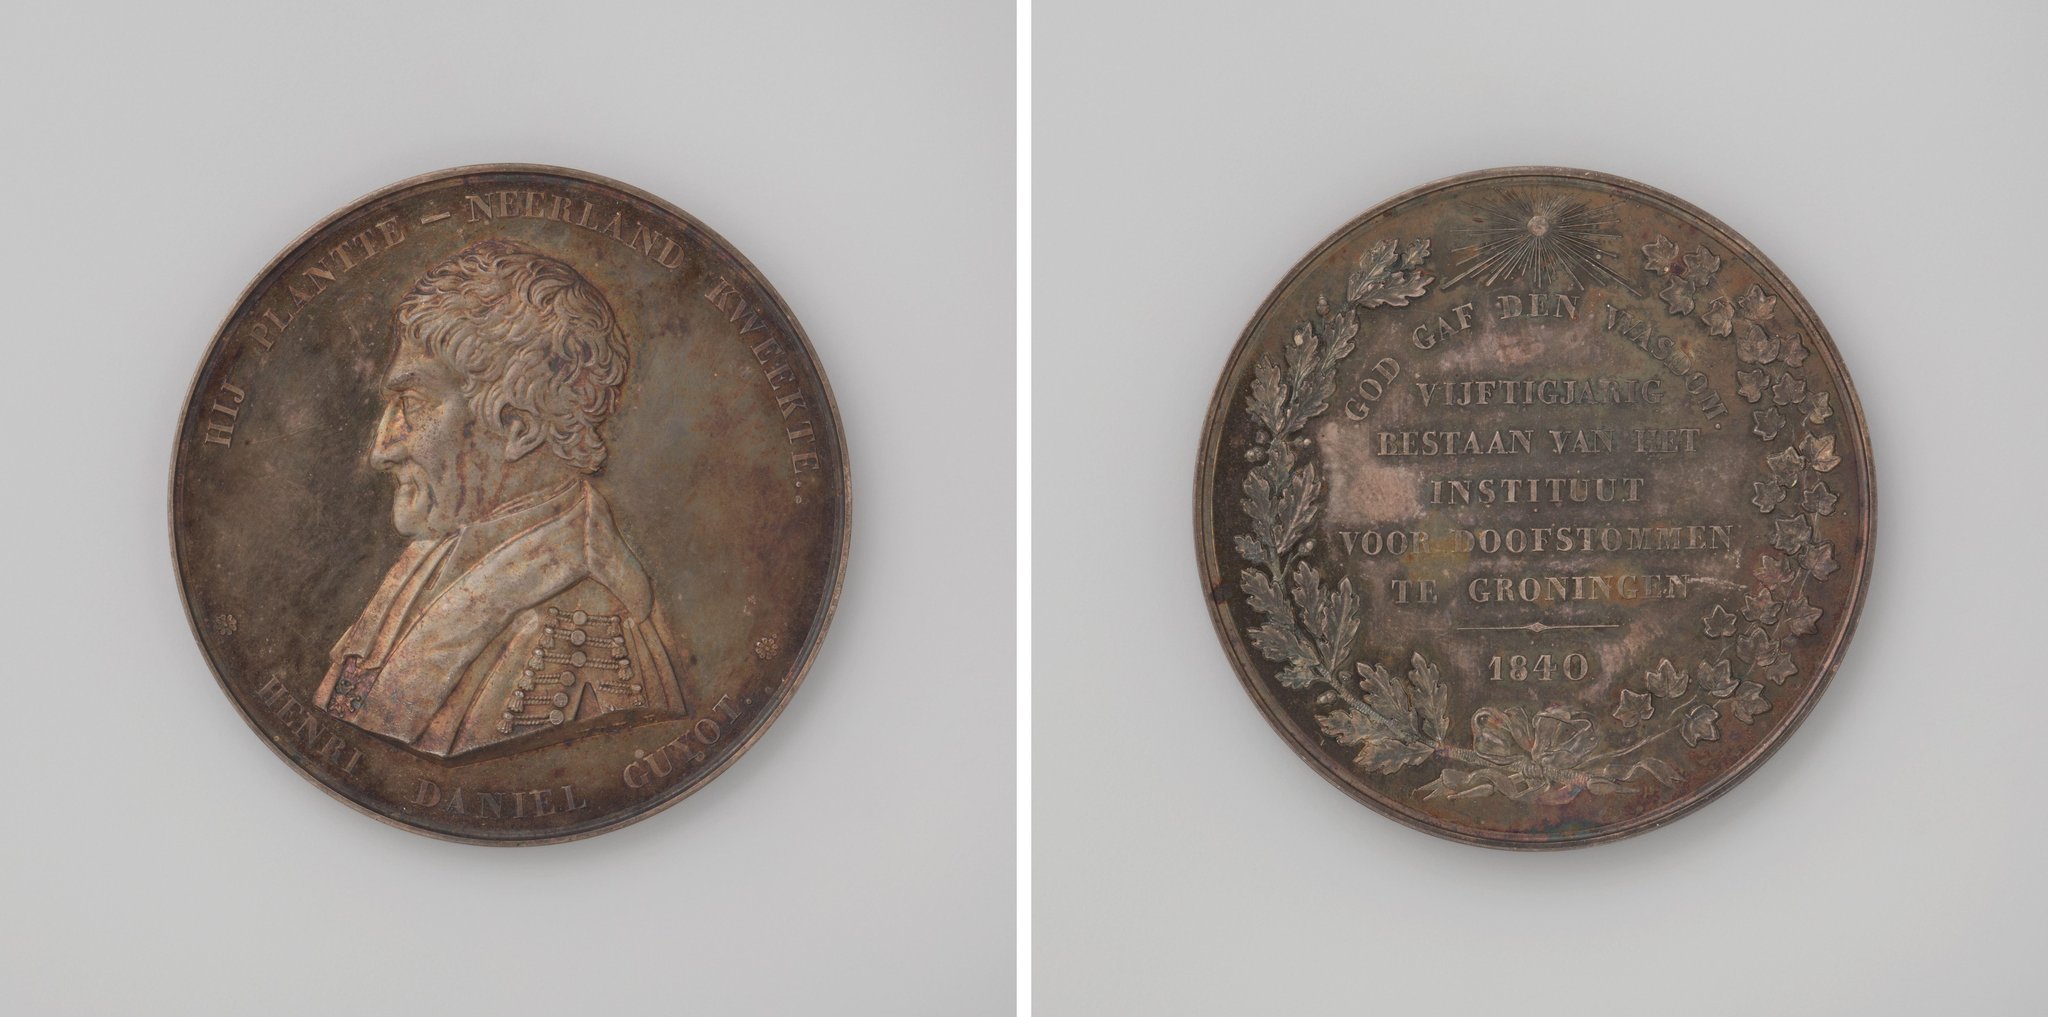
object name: history medal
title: Penning ter ere van het vijftigjarig bestaan van het door Henri Daniel Guyot opgerichte Instituut voor Doofstommen te Groningen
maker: david van der kellen (1804-1879)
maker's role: die cutter, draughtsman, print maker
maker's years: 1804-1879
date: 1840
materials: silver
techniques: striking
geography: utrecht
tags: france, deaf, deafness, specialized institutions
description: Zilveren penning. Voorzijde: borststuk man binnen omschrift. Keerzijde: opschrift binnen omschrift en tot krans samengebonden eiken- en klimoptak, beschenen door hemellicht.